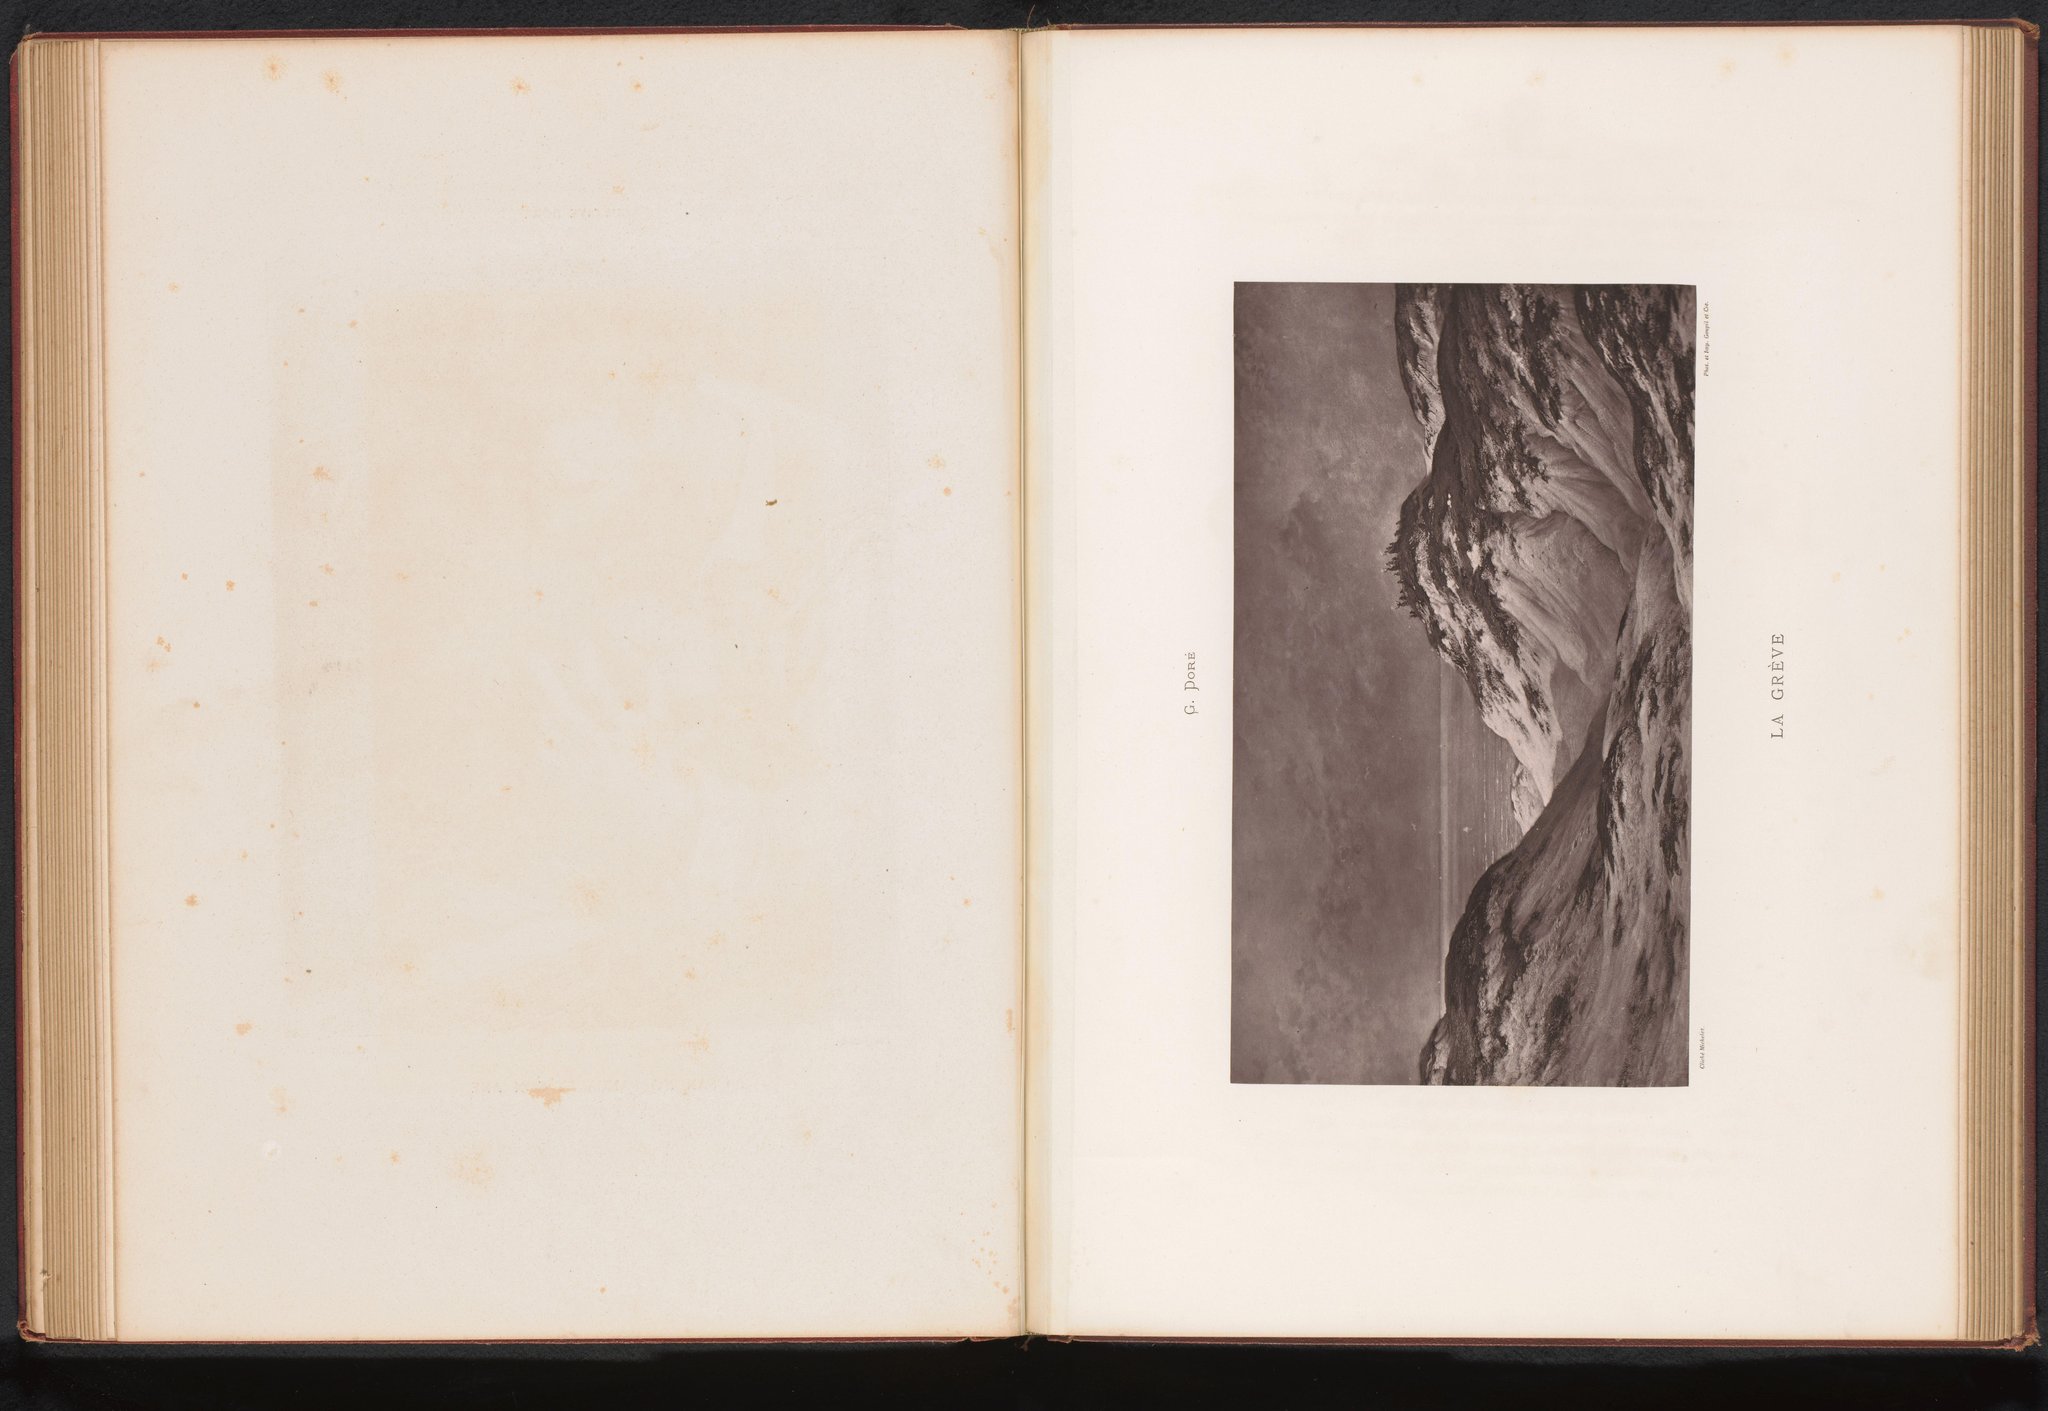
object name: photomechanical print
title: Reproductie van La Grève door Gustave Doré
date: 1874-1879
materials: paper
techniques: woodburytype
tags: landscapes with waters, waterscapes, seascapes (in the temperate zone) (+ landscape with figures, staffage), strike (political demonstration)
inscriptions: name: ‘G. Doré’